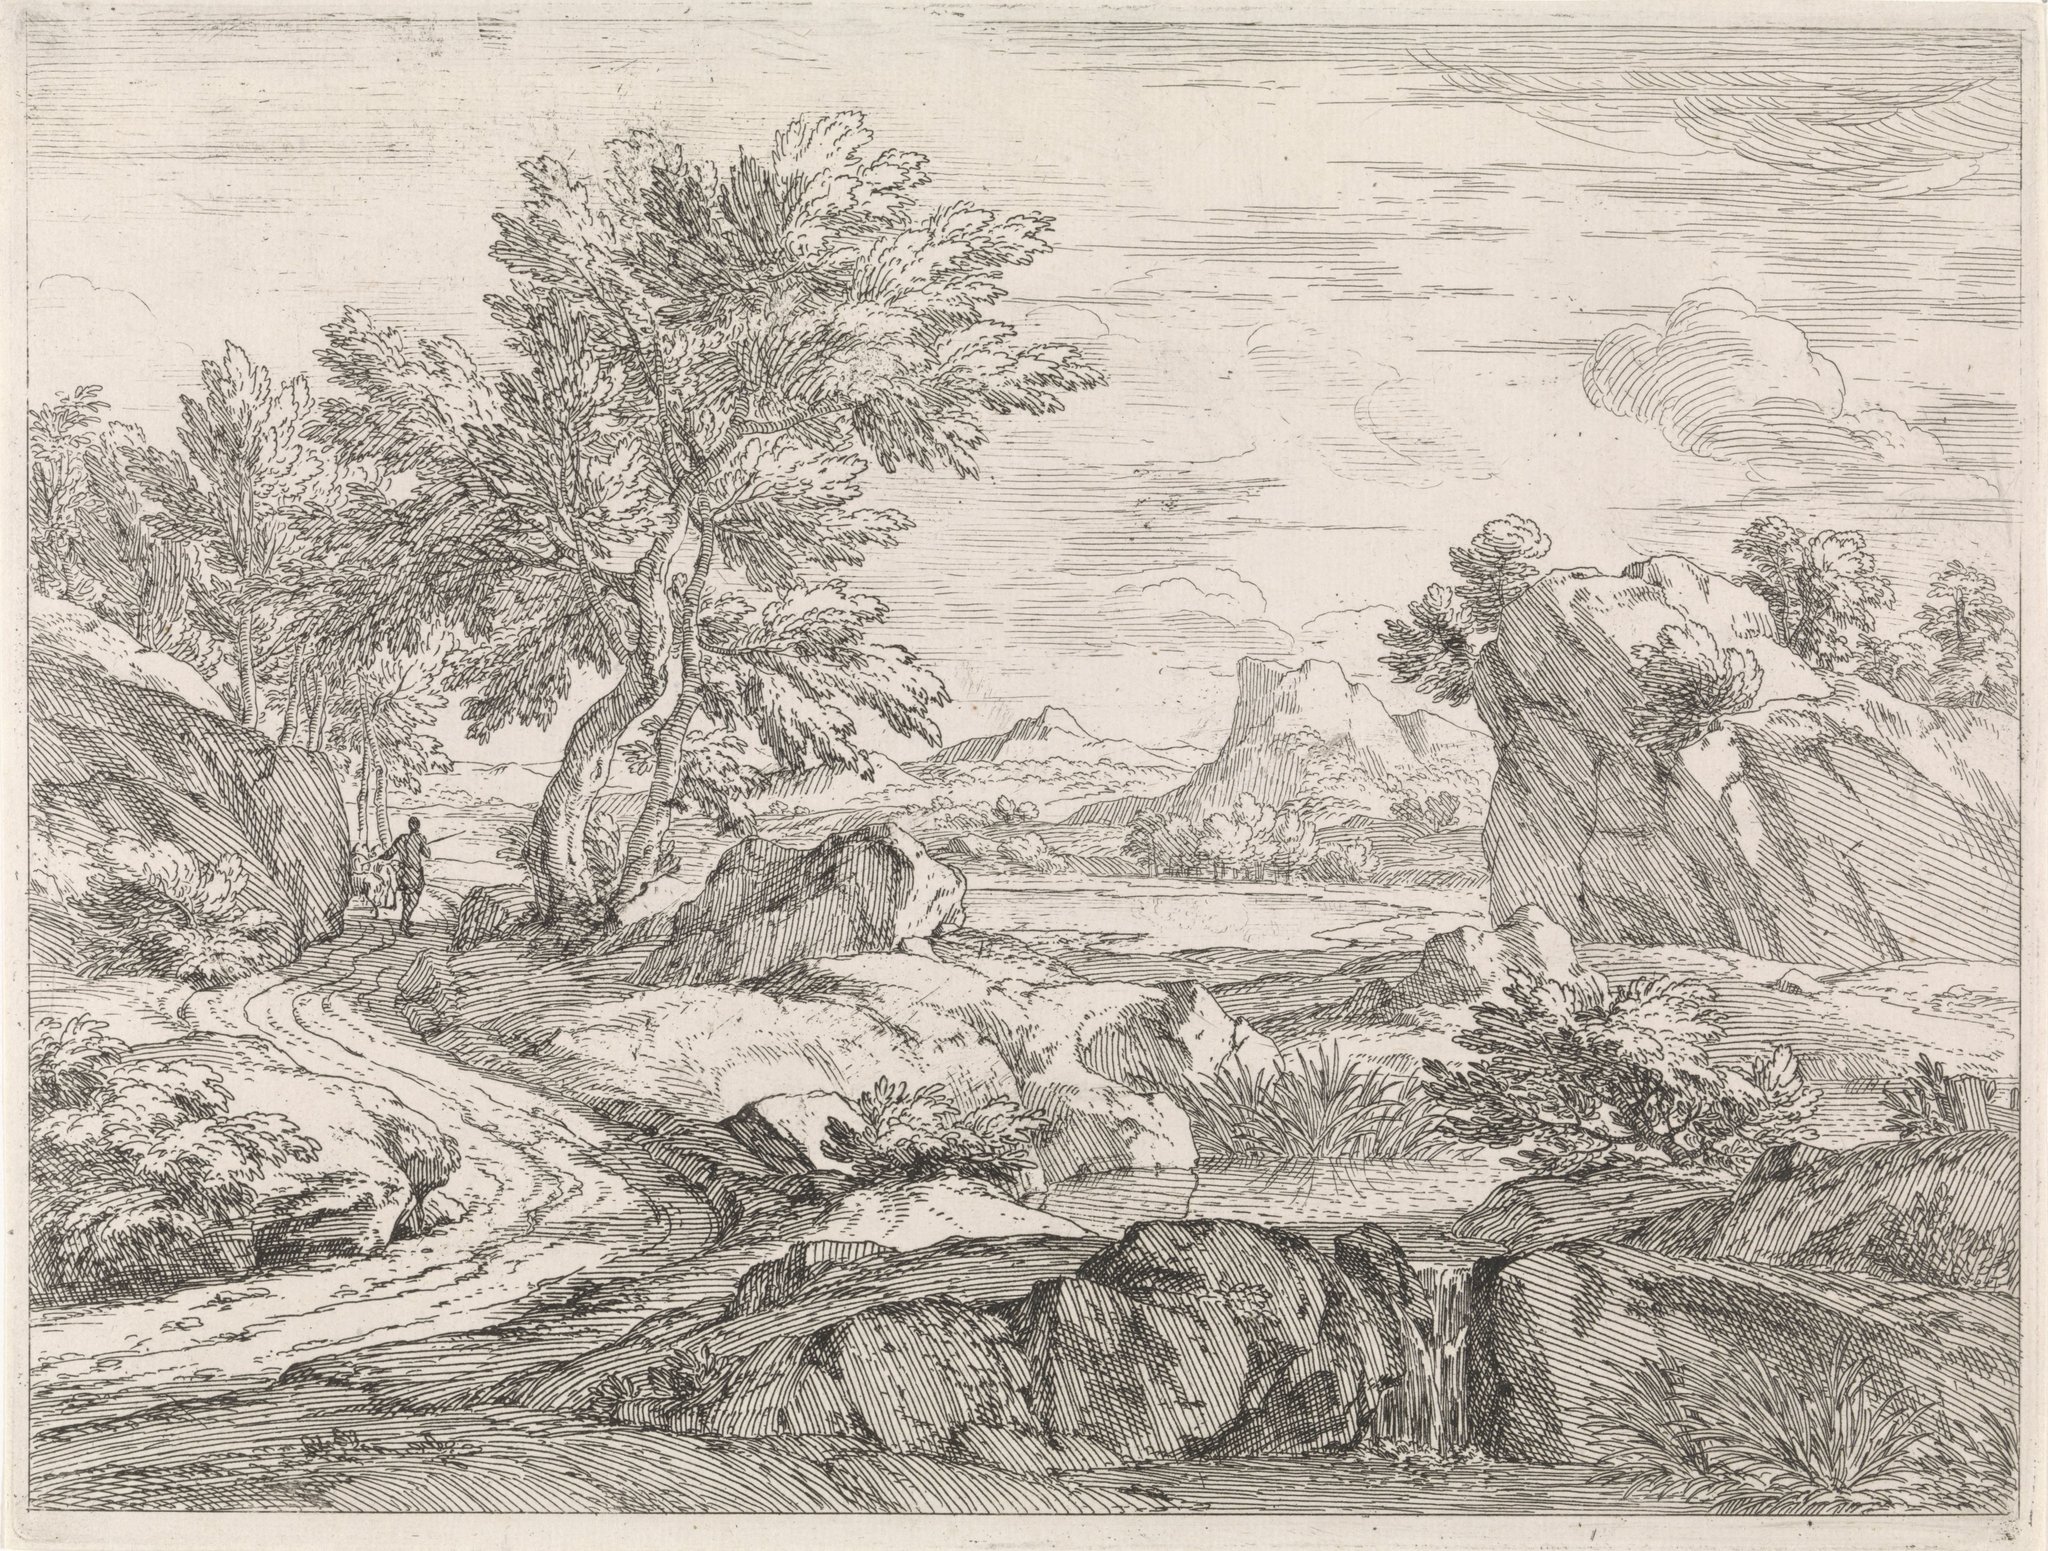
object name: print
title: Landschap met rotsen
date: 1650-1690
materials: paper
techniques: etching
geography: paris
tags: waterfall, brook, rock-formations, public road (+ city(-scape) with figures, staffage)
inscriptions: collector's mark: Lugt 240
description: Een landschap met rotsen en een weg. Naast de weg een kleine beek en een waterval. De prent maakt deel uit van een serie van rivierlandschappen.